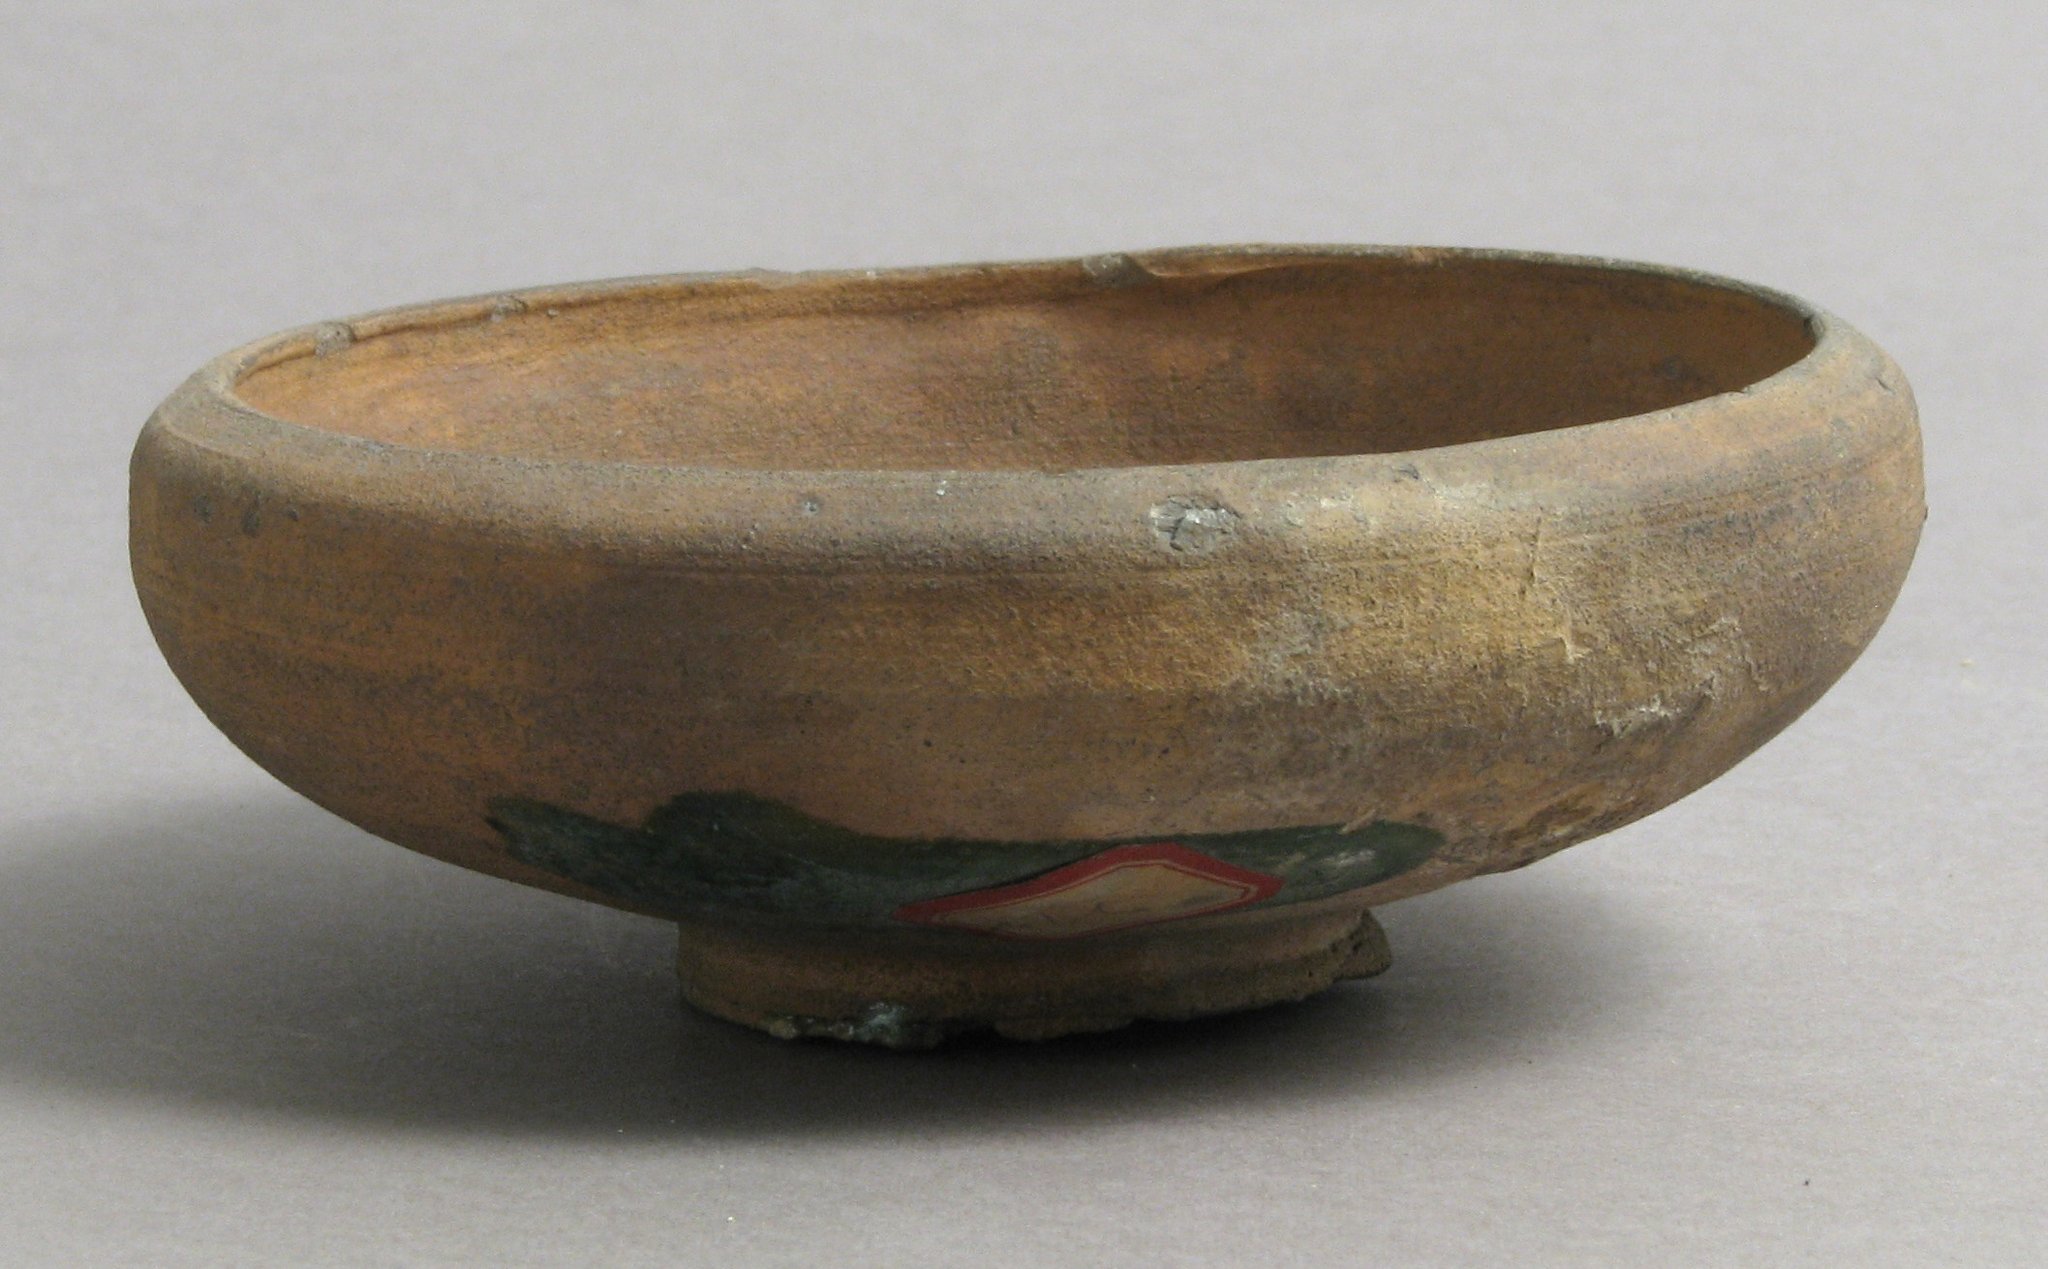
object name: dish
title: Dish, Deep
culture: french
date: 1401-1600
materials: earthenware